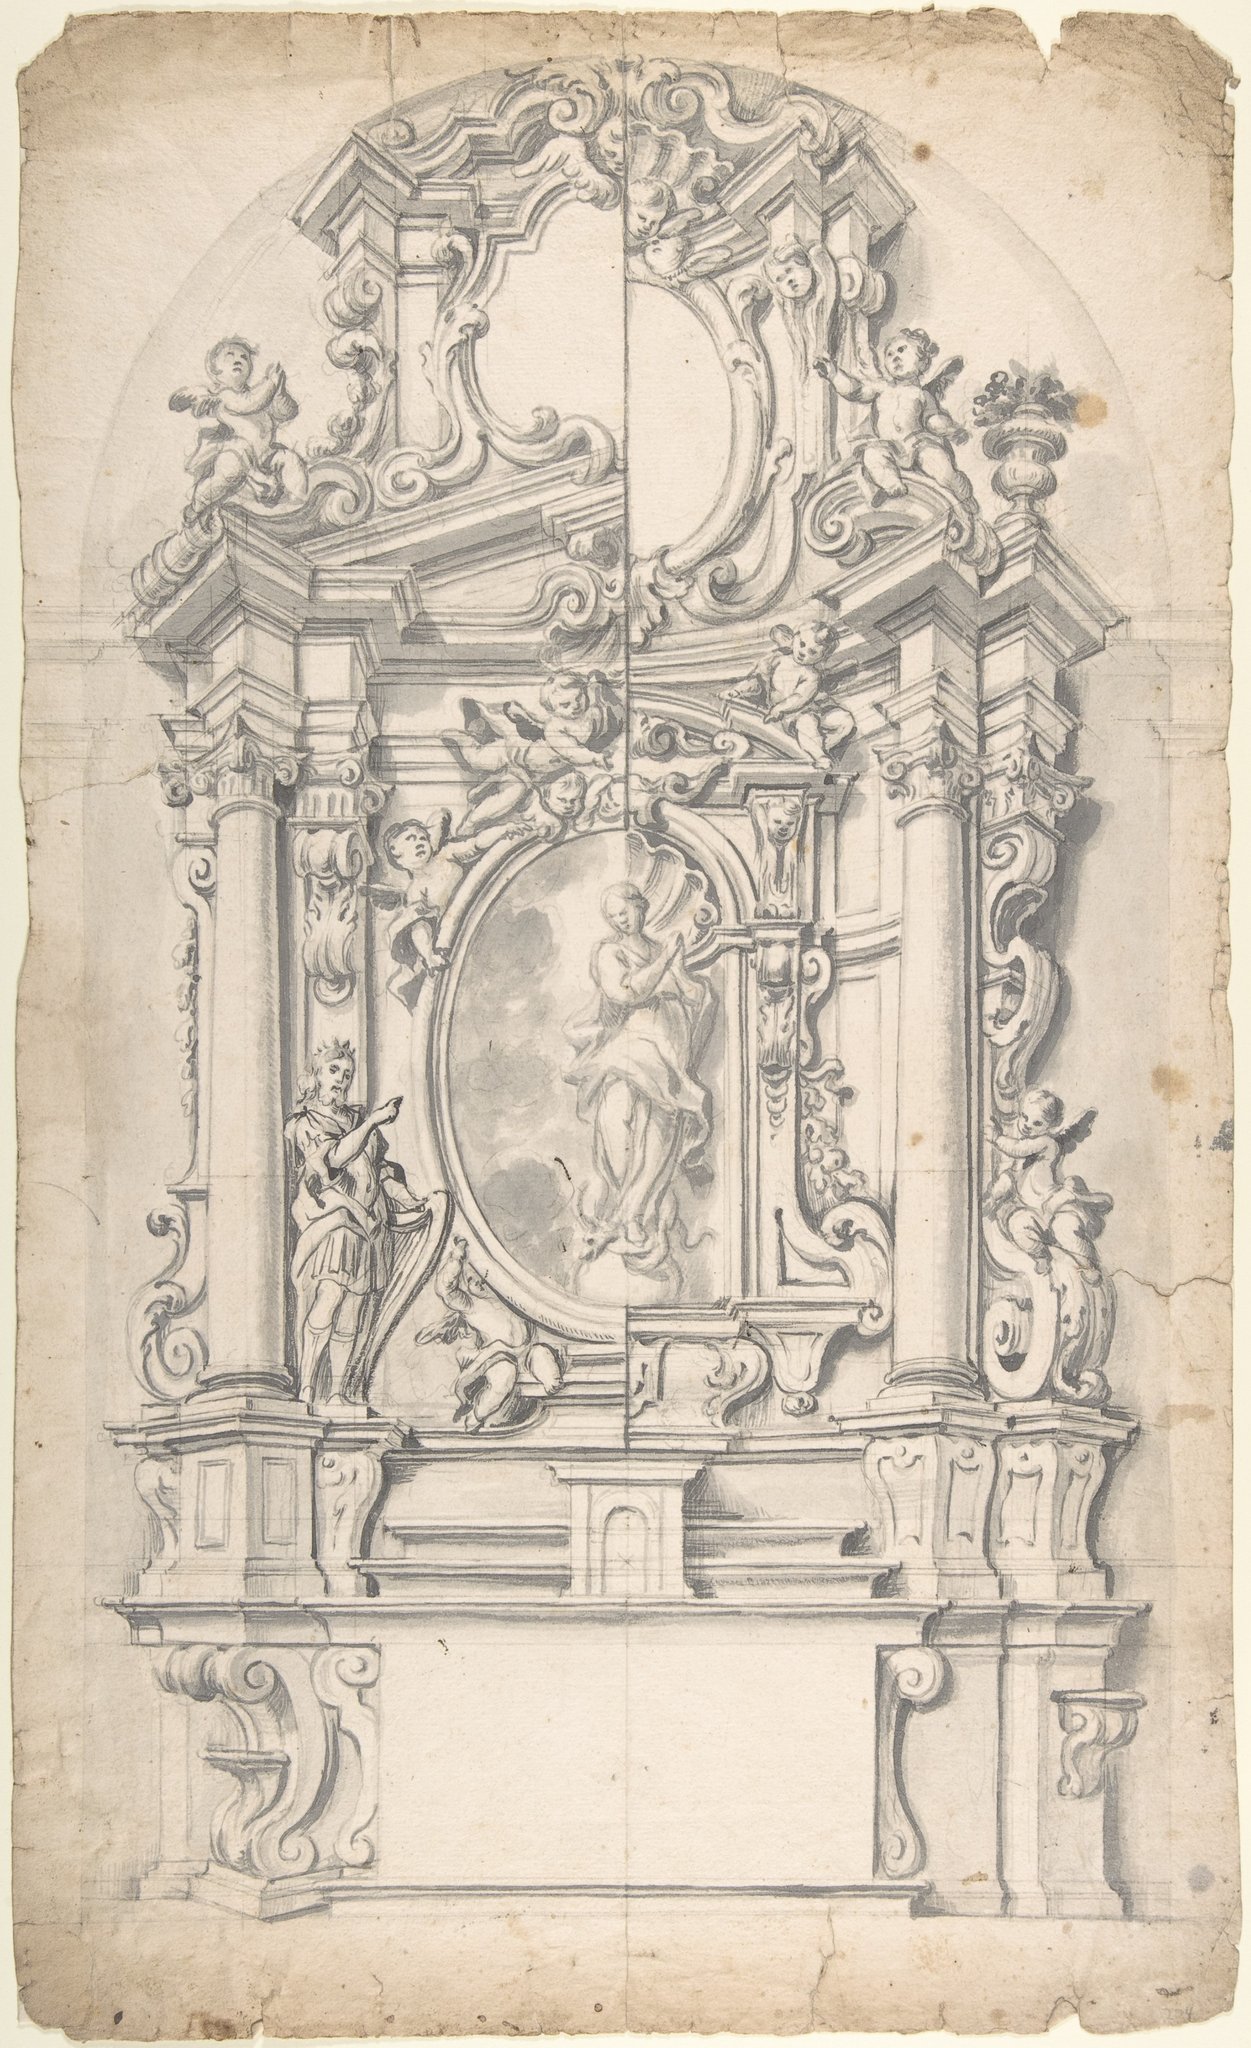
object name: drawing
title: Halved Variant Designs for an Altar with the Virgin of the Immaculate Conception in the Central Cartouche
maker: anonymous, italian, piedmontese, 18th century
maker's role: artist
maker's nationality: italian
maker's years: 1700-1800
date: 1700-1780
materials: graphite, ink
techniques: brush, incising, pen, wash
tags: altars,virgin mary